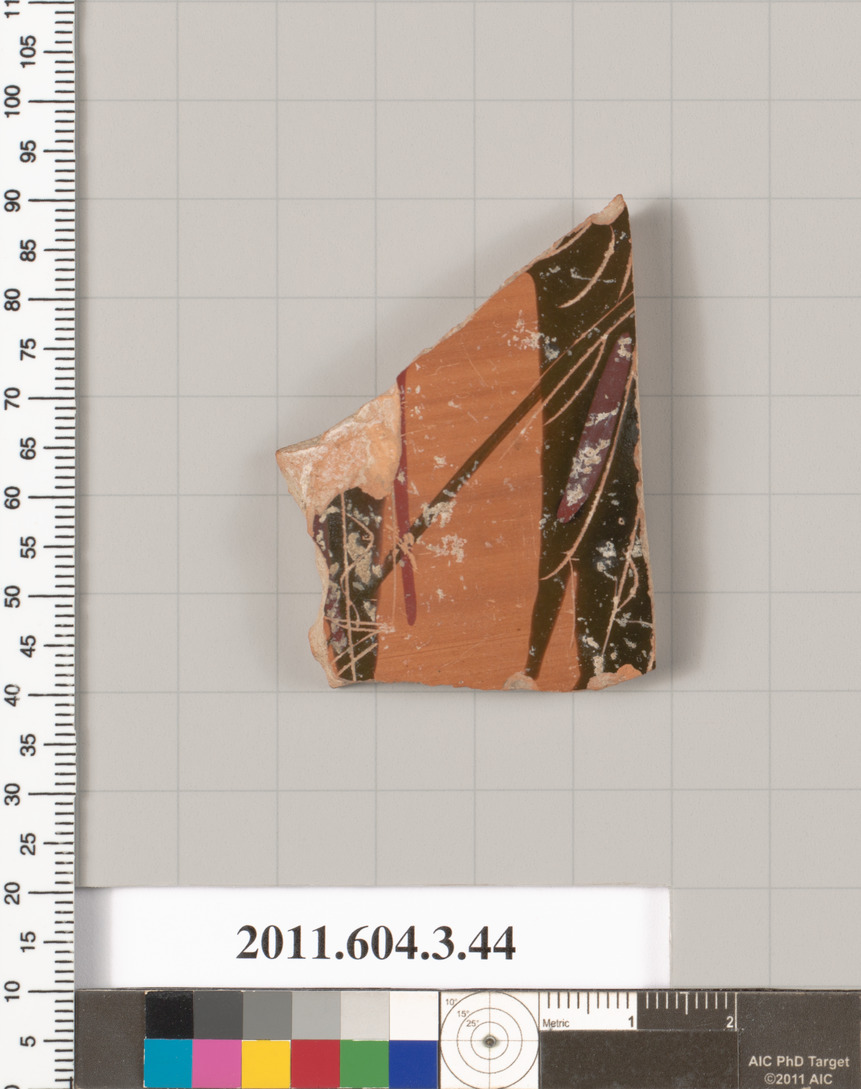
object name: amphora fragment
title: Terracotta fragment of an amphora (jar)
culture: greek, attic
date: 520-510 BCE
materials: terracotta